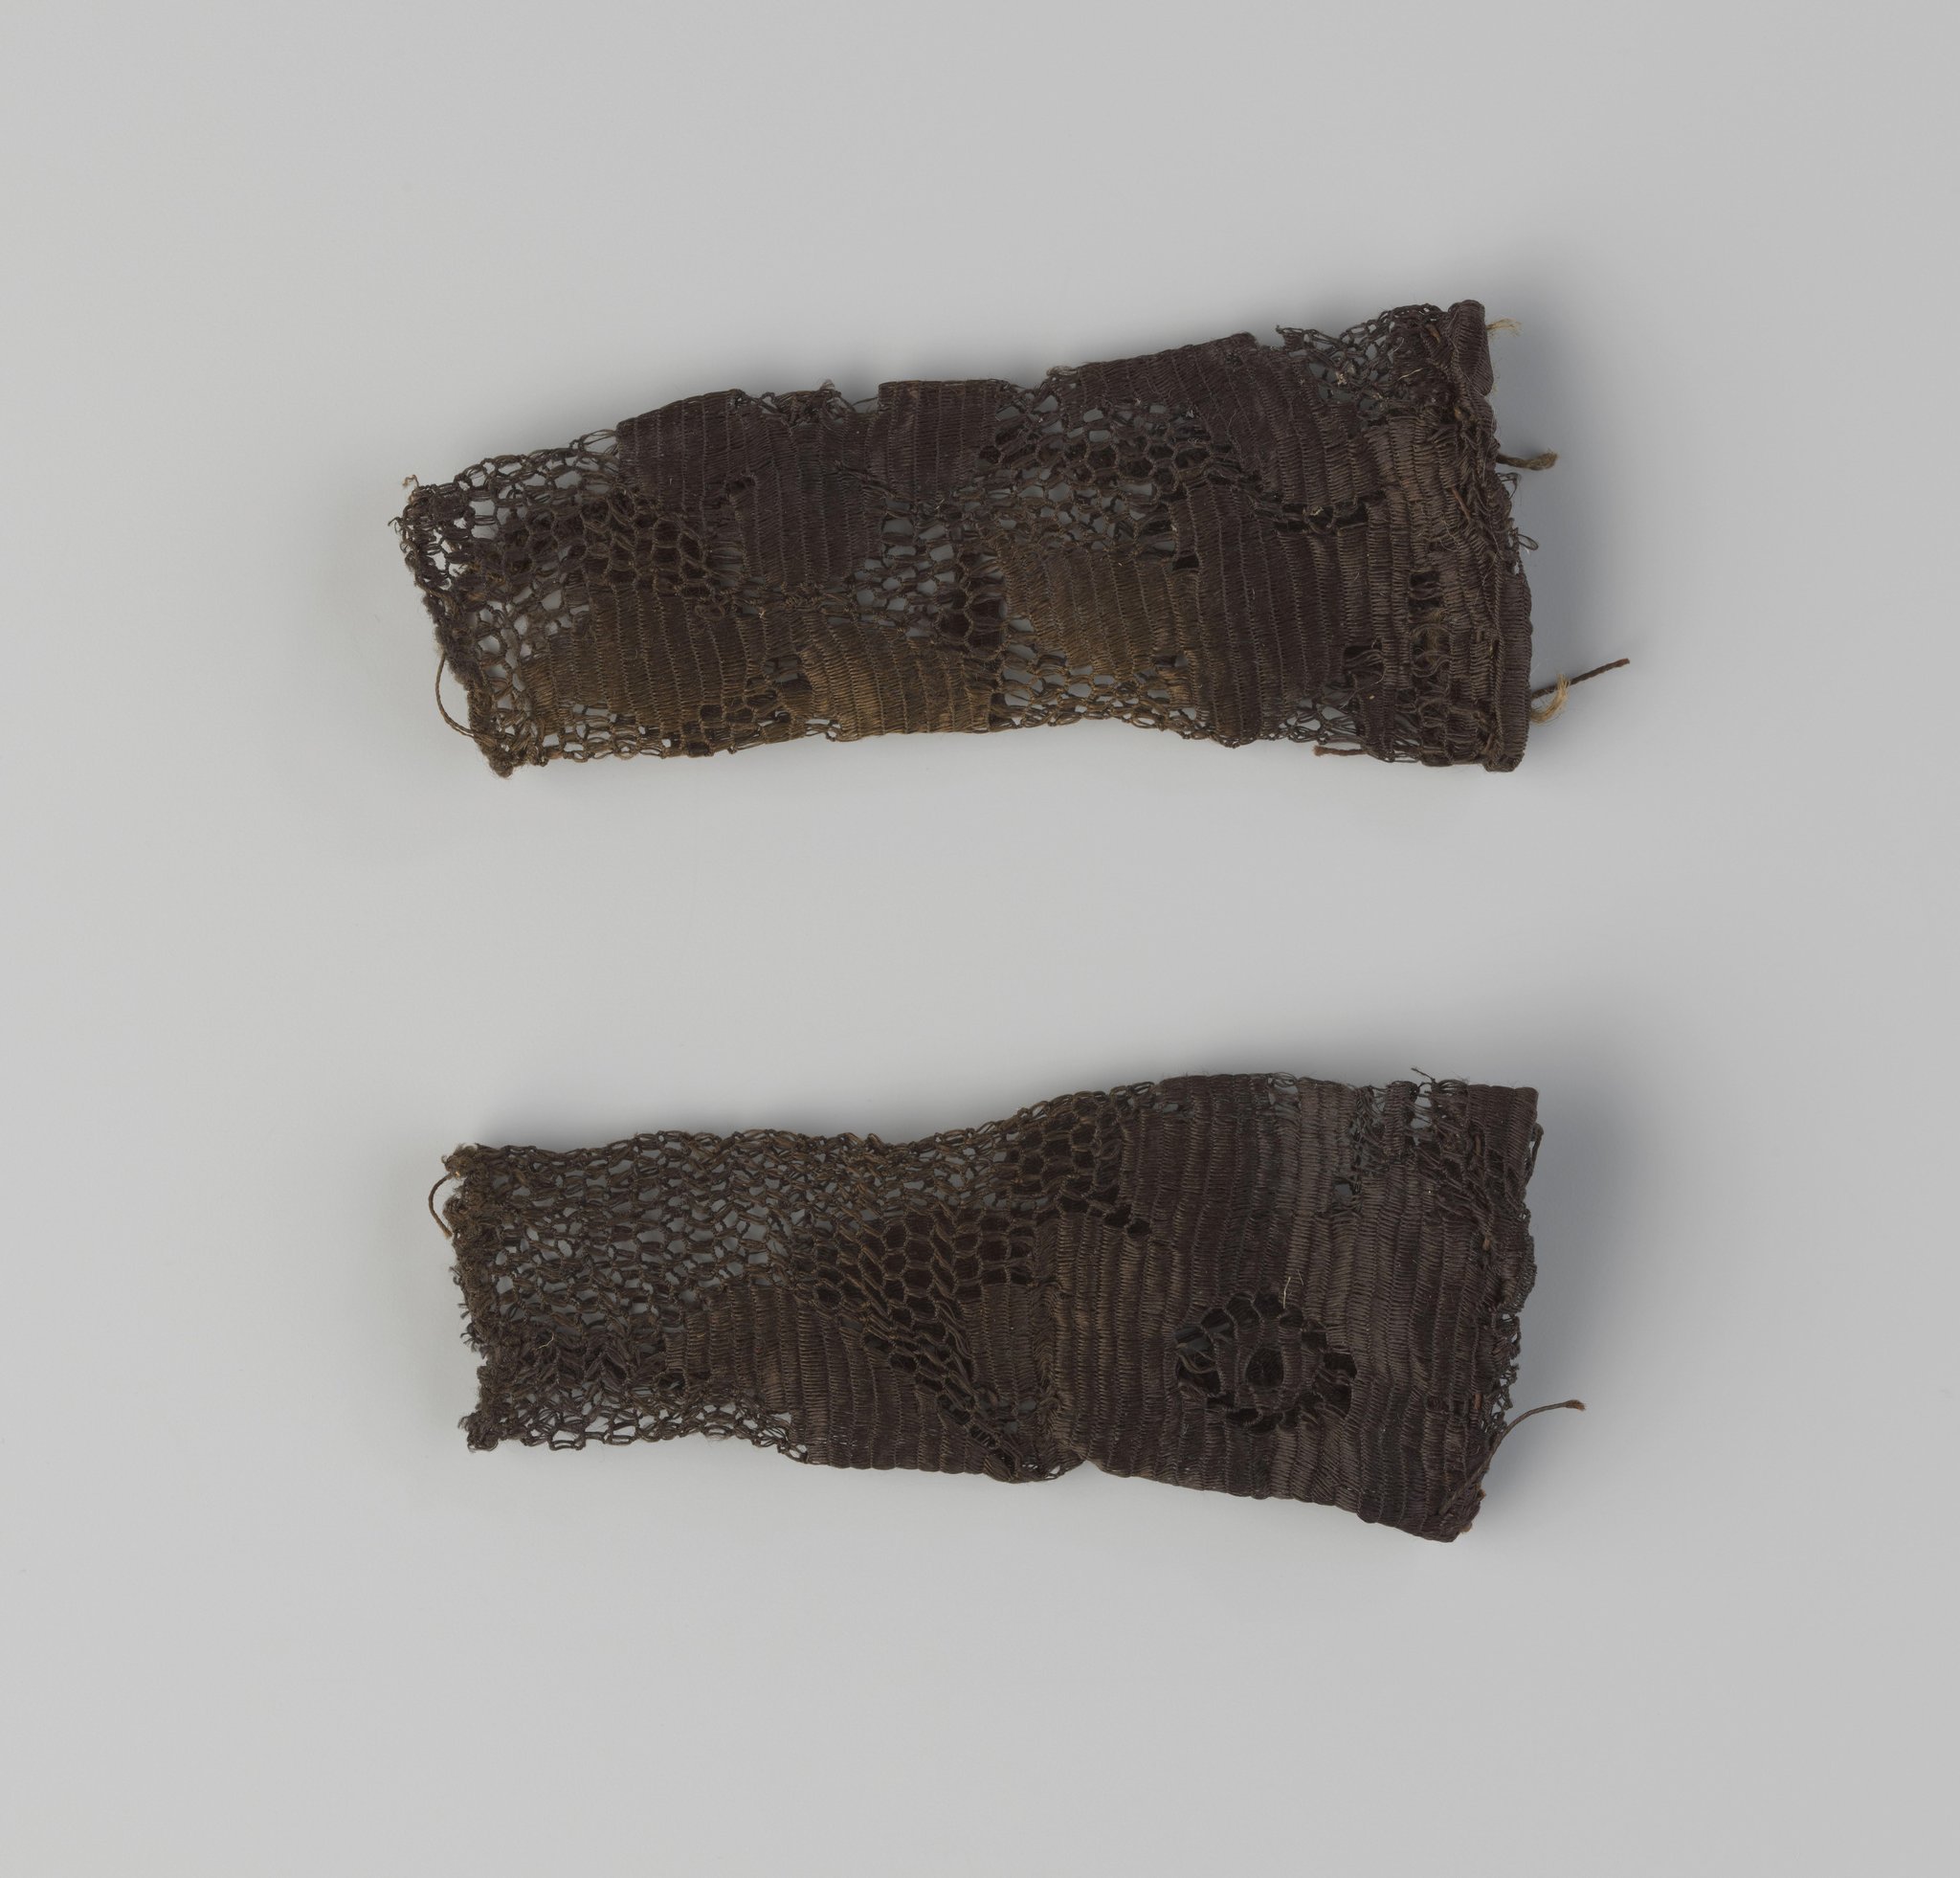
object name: doll's clothing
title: Mouw van zwart kant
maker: Anonymous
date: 1850-1920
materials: lace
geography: europe